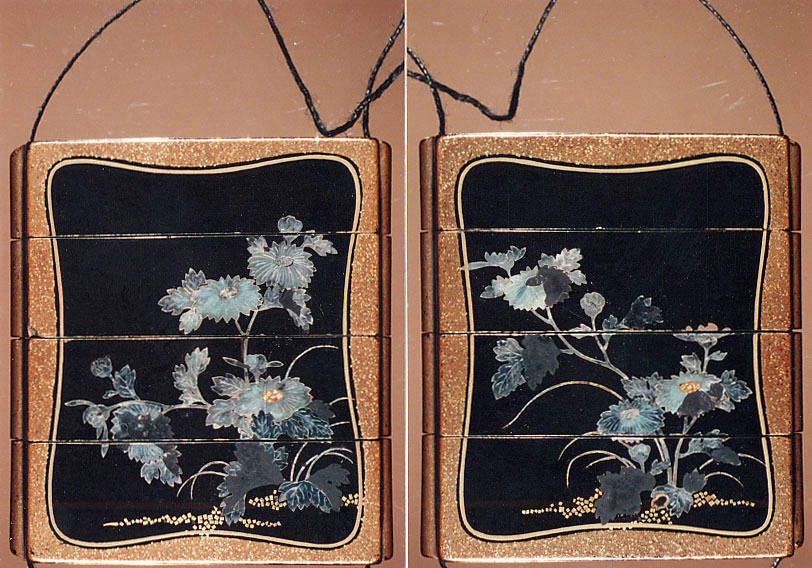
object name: inrō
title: Case (Inrō) with Design of Flowering Chrysanthemums with Brocade Borders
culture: japanese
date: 1701-1900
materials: gold foil, lacquer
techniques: fundame, inlay, roiro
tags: flowers